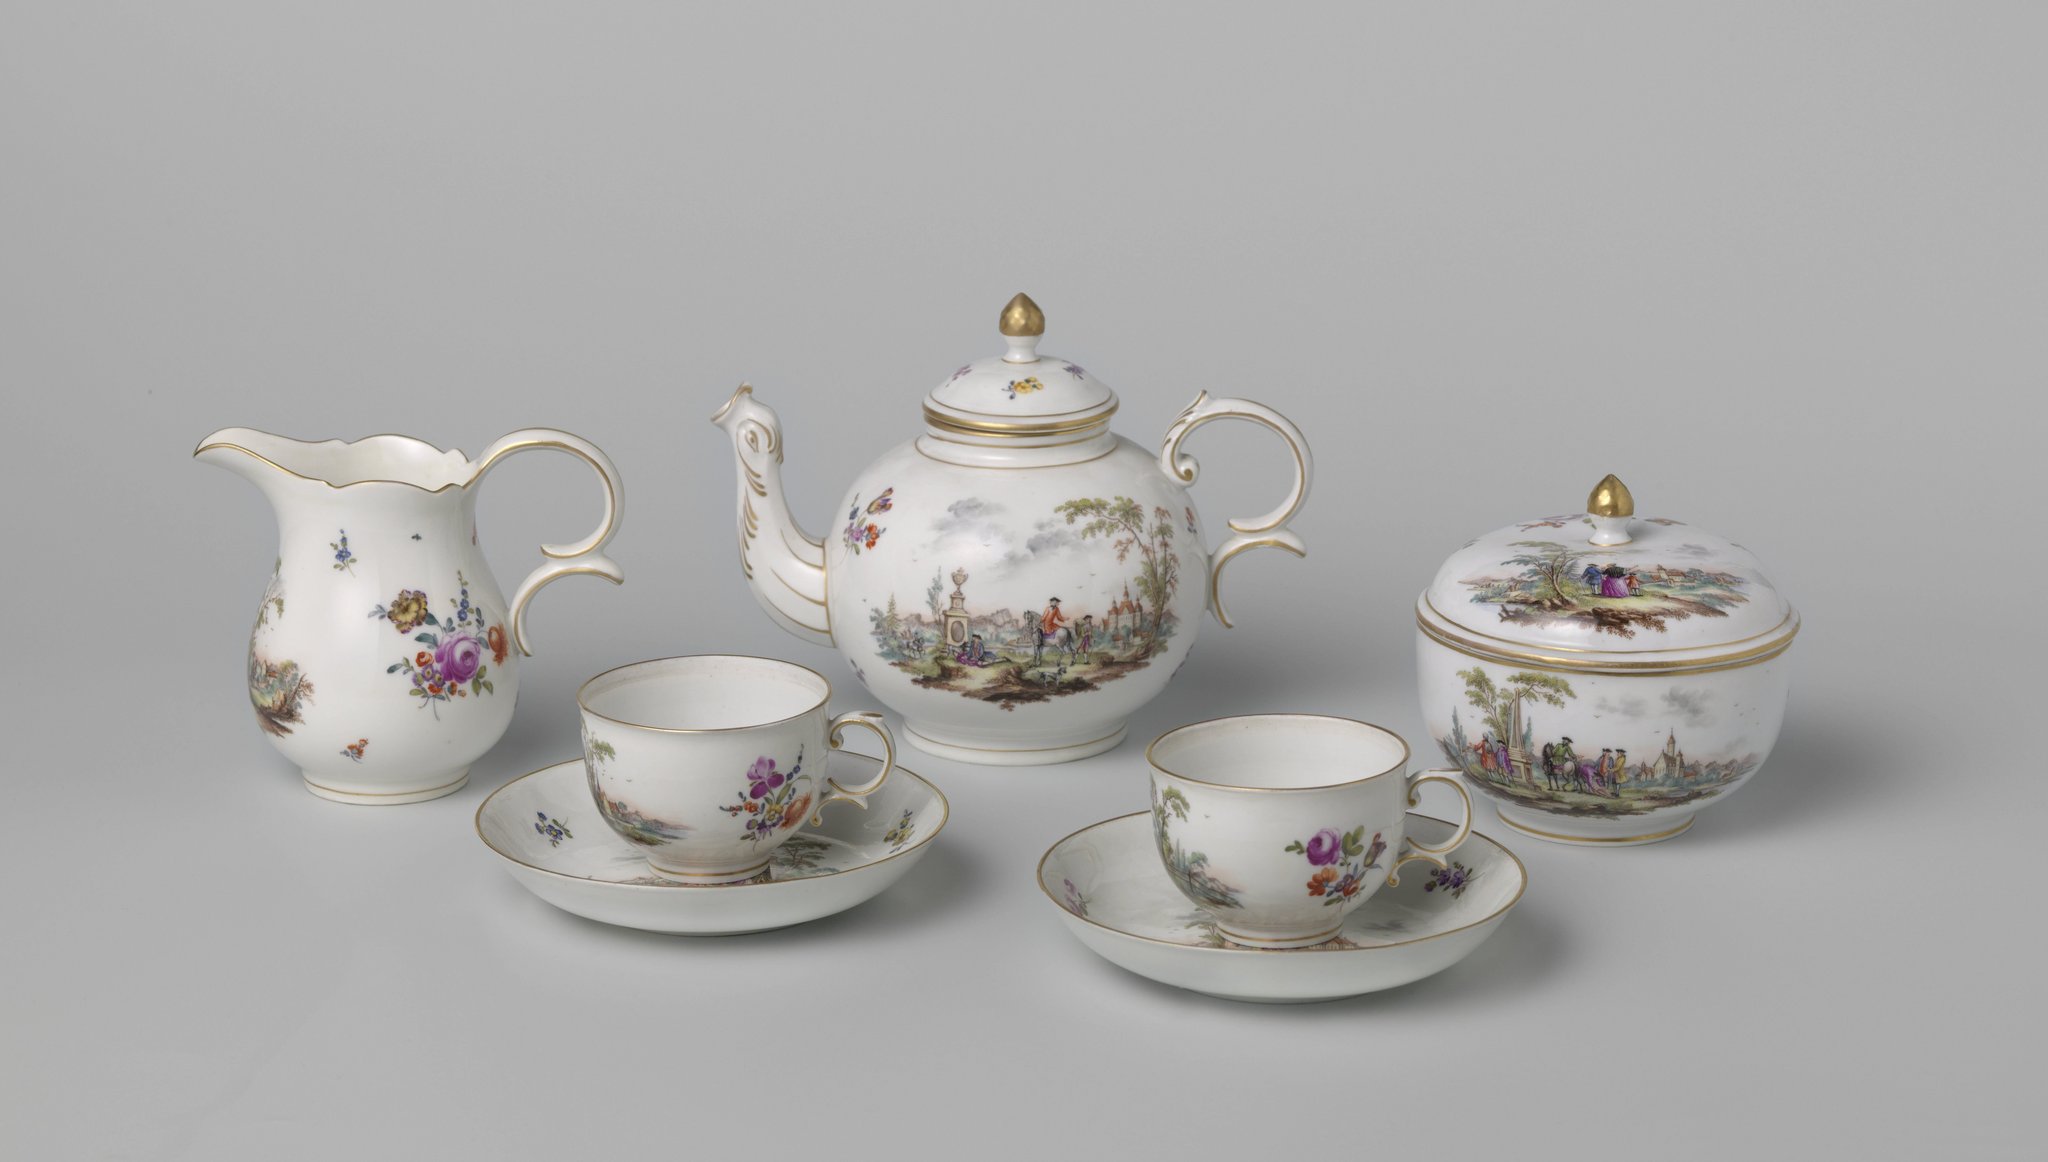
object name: tea service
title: Tea service with landscapes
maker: Anonymous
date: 1765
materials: glaze, gold, paint, porcelain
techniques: firing, forming, gilding, vitrification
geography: sint-petersburg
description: Theeservies van porselein, beschilderd op het glazuur in emailkleuren en goud. Het servies bestaat uit vijf delen, waaronder een theepot, melkkan, suikerpot en twee koppen met schotels. Allen versierd met landschappen. Gemerkt met het monogram van Catherine II van Rusland. Mogelijk een 19e of 20e eeuwse vervalsing.